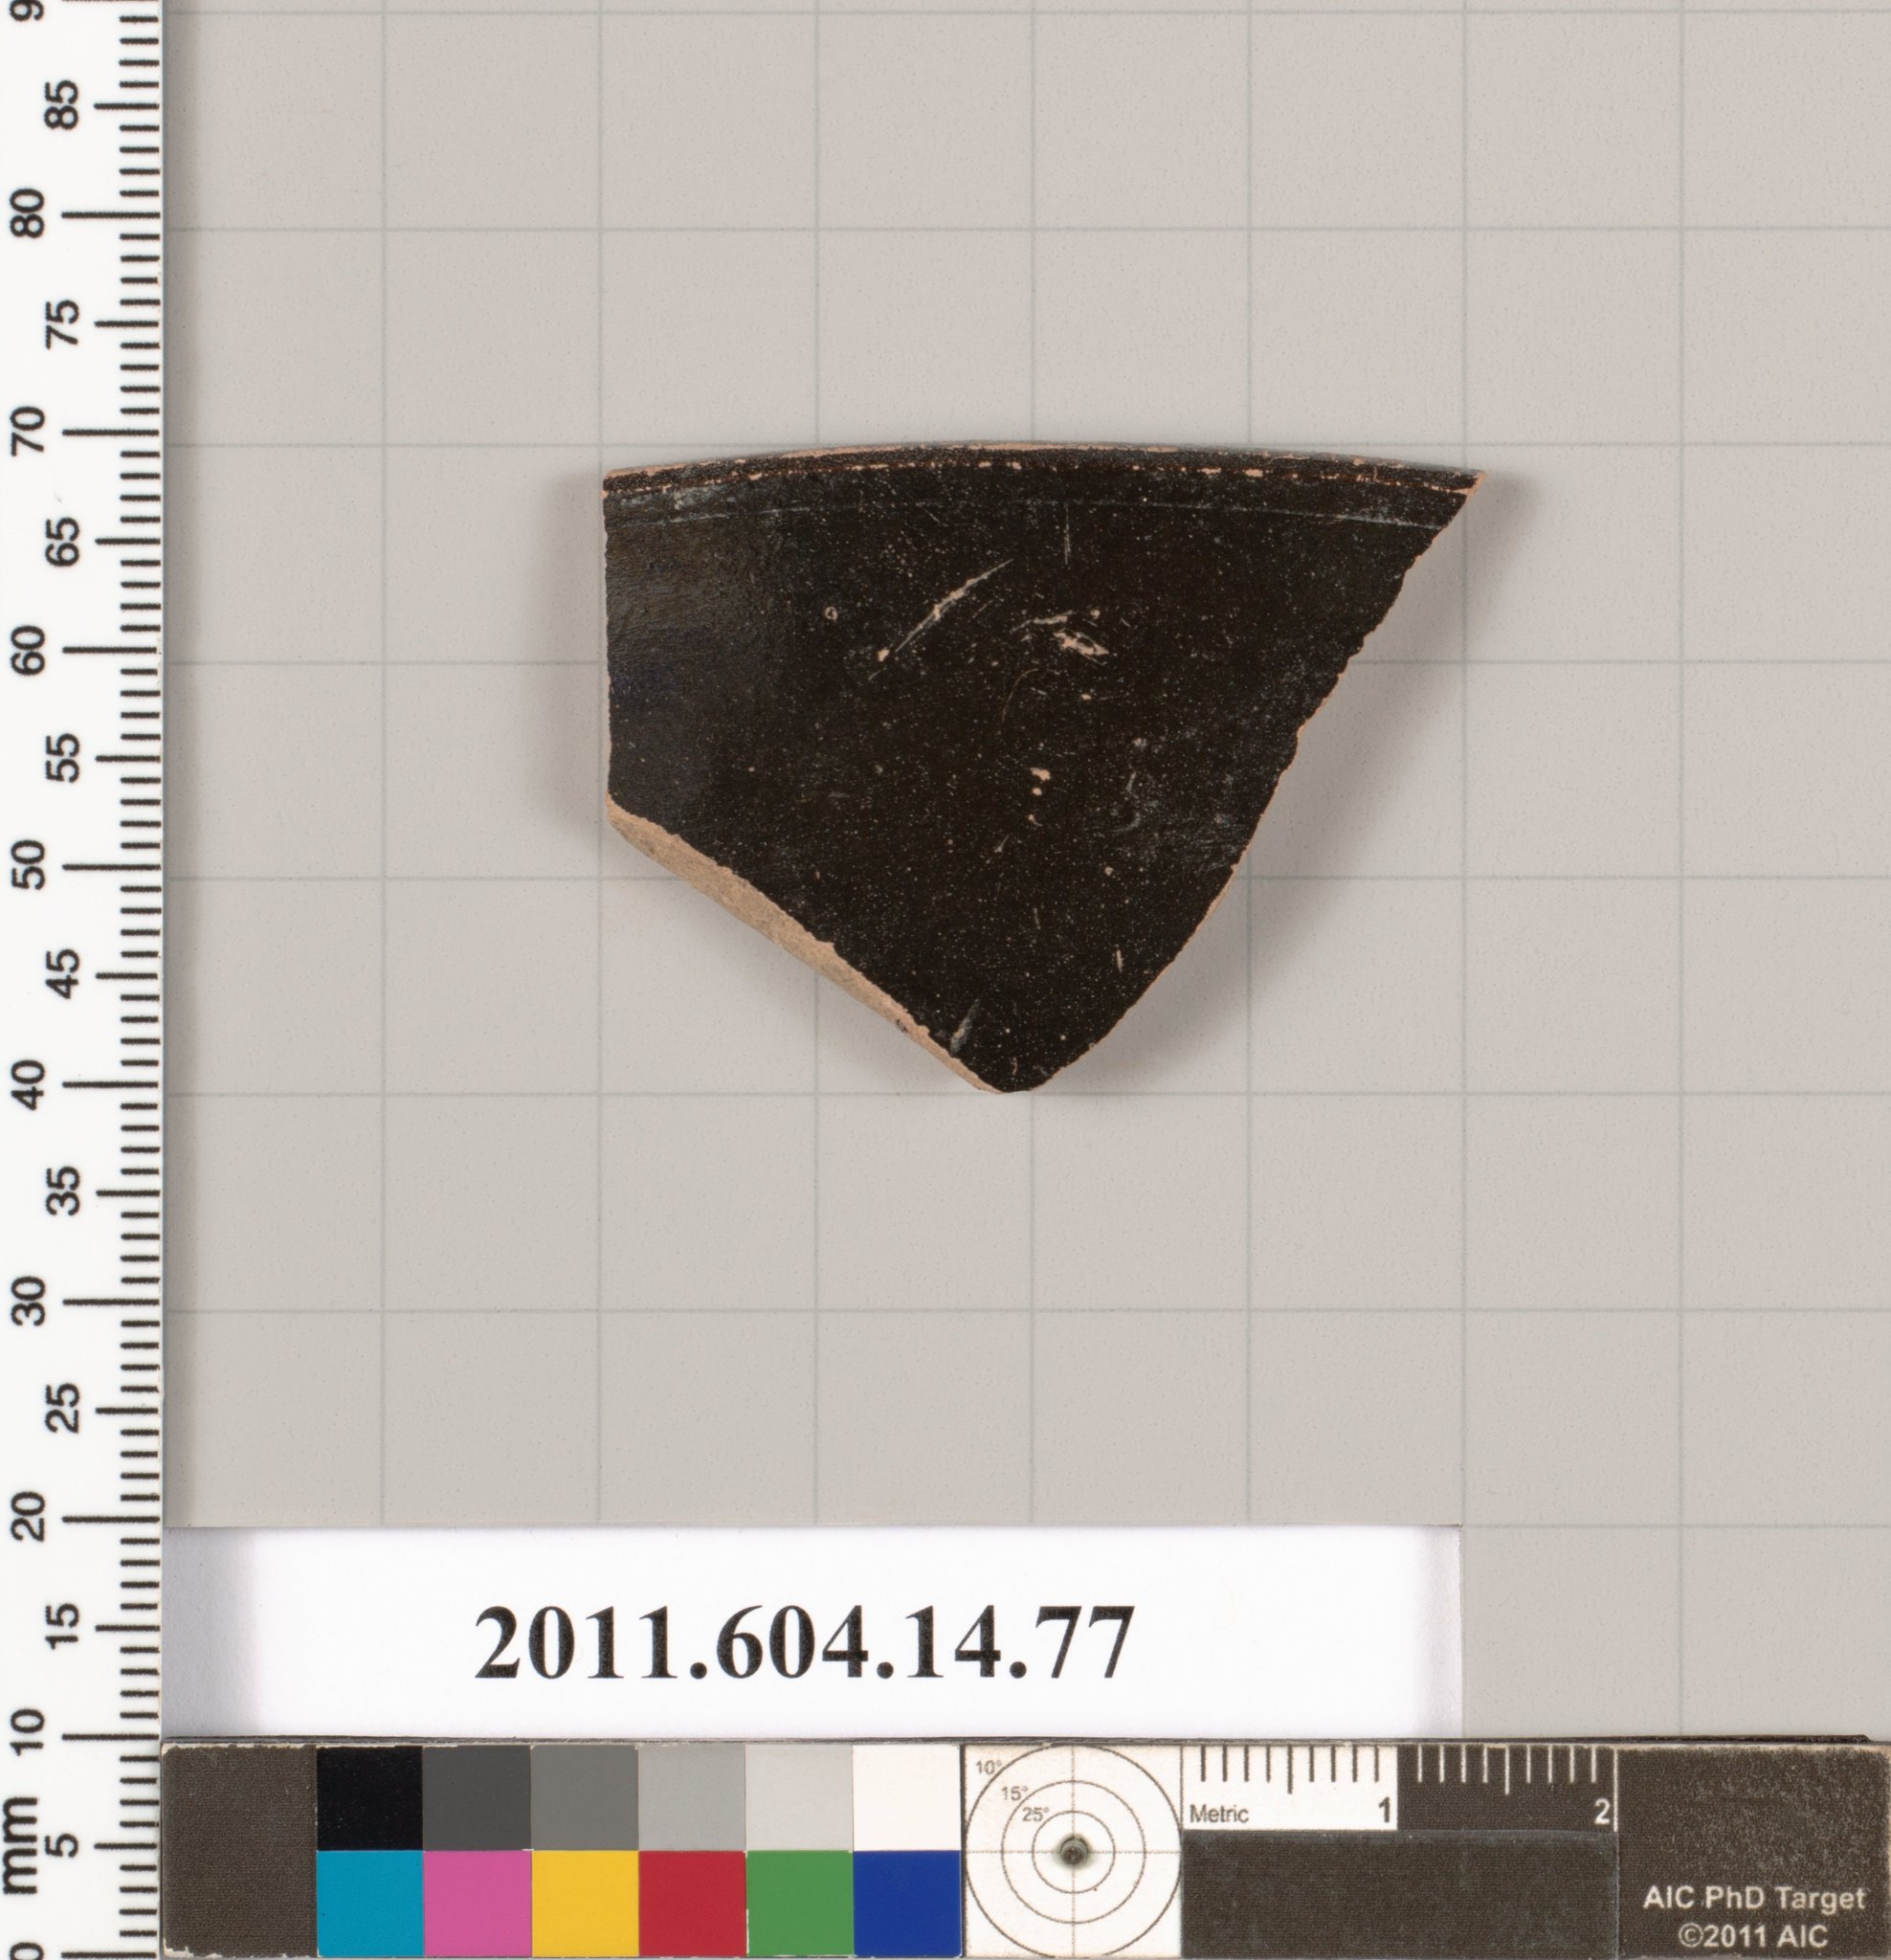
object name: undetermined open shape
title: Terracotta rim fragment of an open shape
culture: unknown fabric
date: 300-201 BCE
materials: terracotta